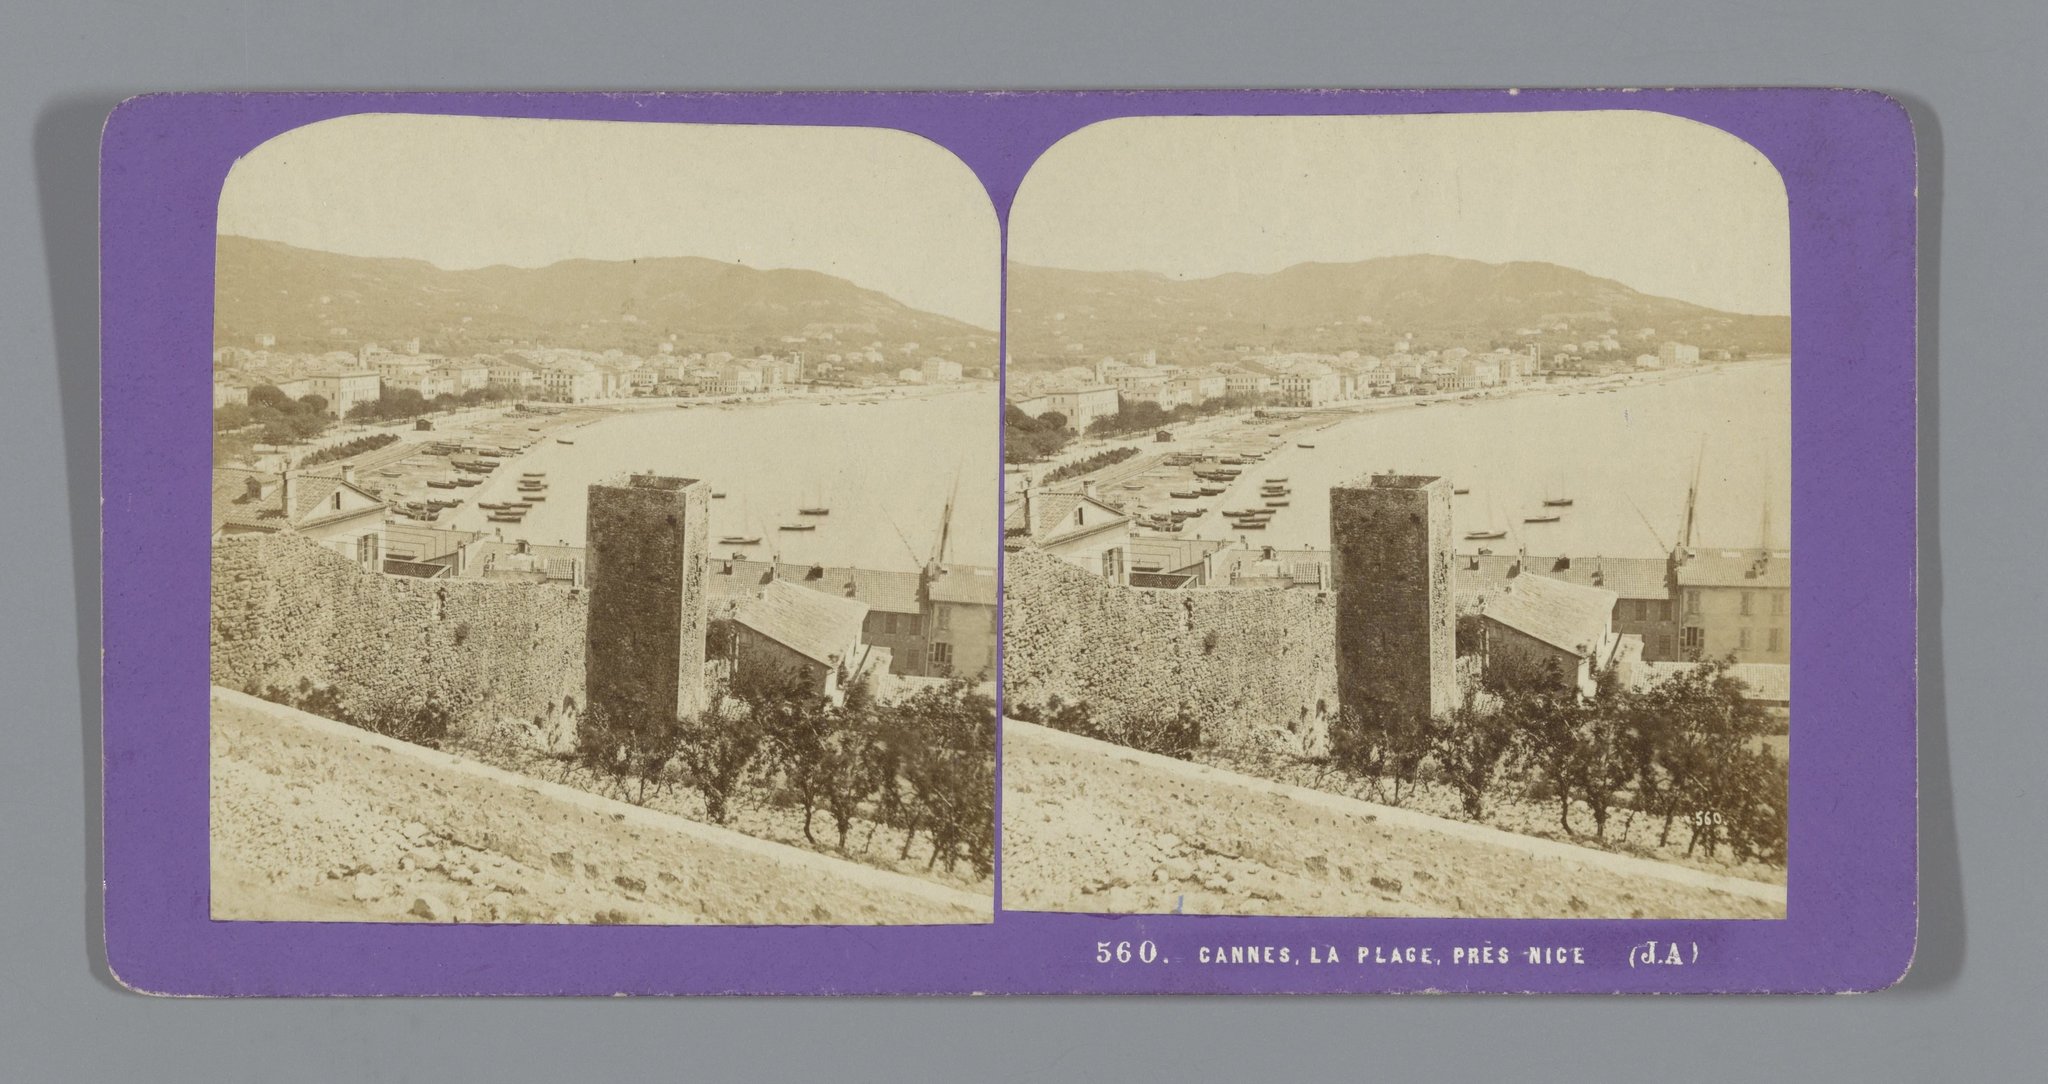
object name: stereograph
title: Gezicht op Cannes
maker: jean andrieu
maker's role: fotograaf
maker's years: 1816-1872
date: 1862-1863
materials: cardboard, photographic support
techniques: albumen print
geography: cannes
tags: city-view in general; 'veduta', coast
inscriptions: number: ‘560.’